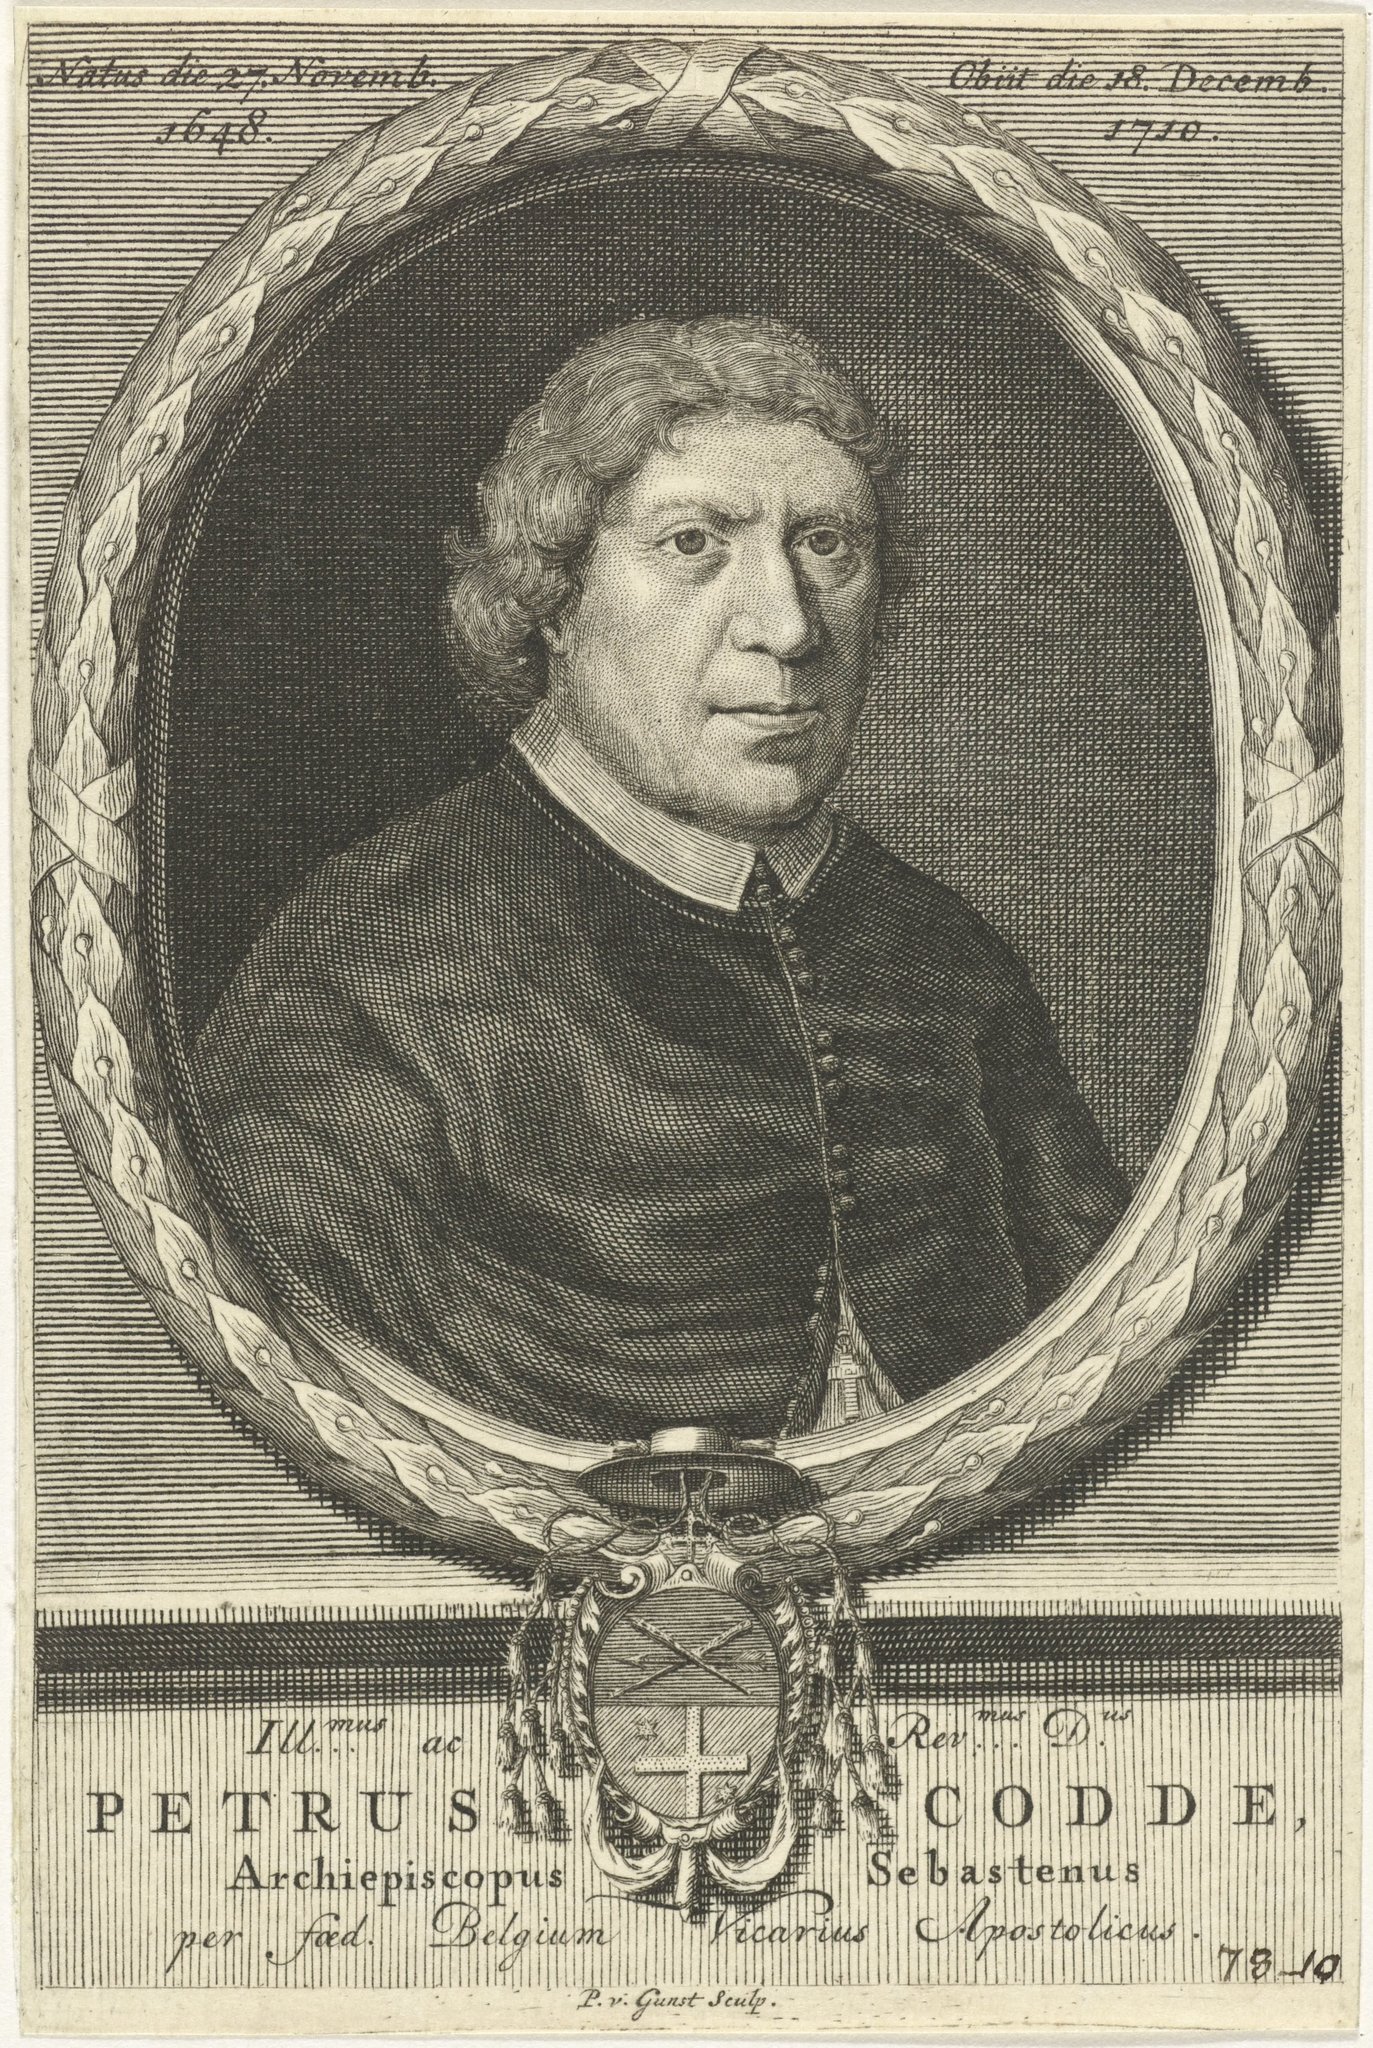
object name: print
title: Portret van aartsbisschop Petrus Codde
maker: pieter van gunst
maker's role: print maker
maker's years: 1658-1731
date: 1710-1731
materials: paper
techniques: engraving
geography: amsterdam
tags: amsterdam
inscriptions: collector's mark: Lugt 2228, number: ‘78-10’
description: Jacob van Catz, apostolisch vicaris en aartsbisschop van Utrecht.